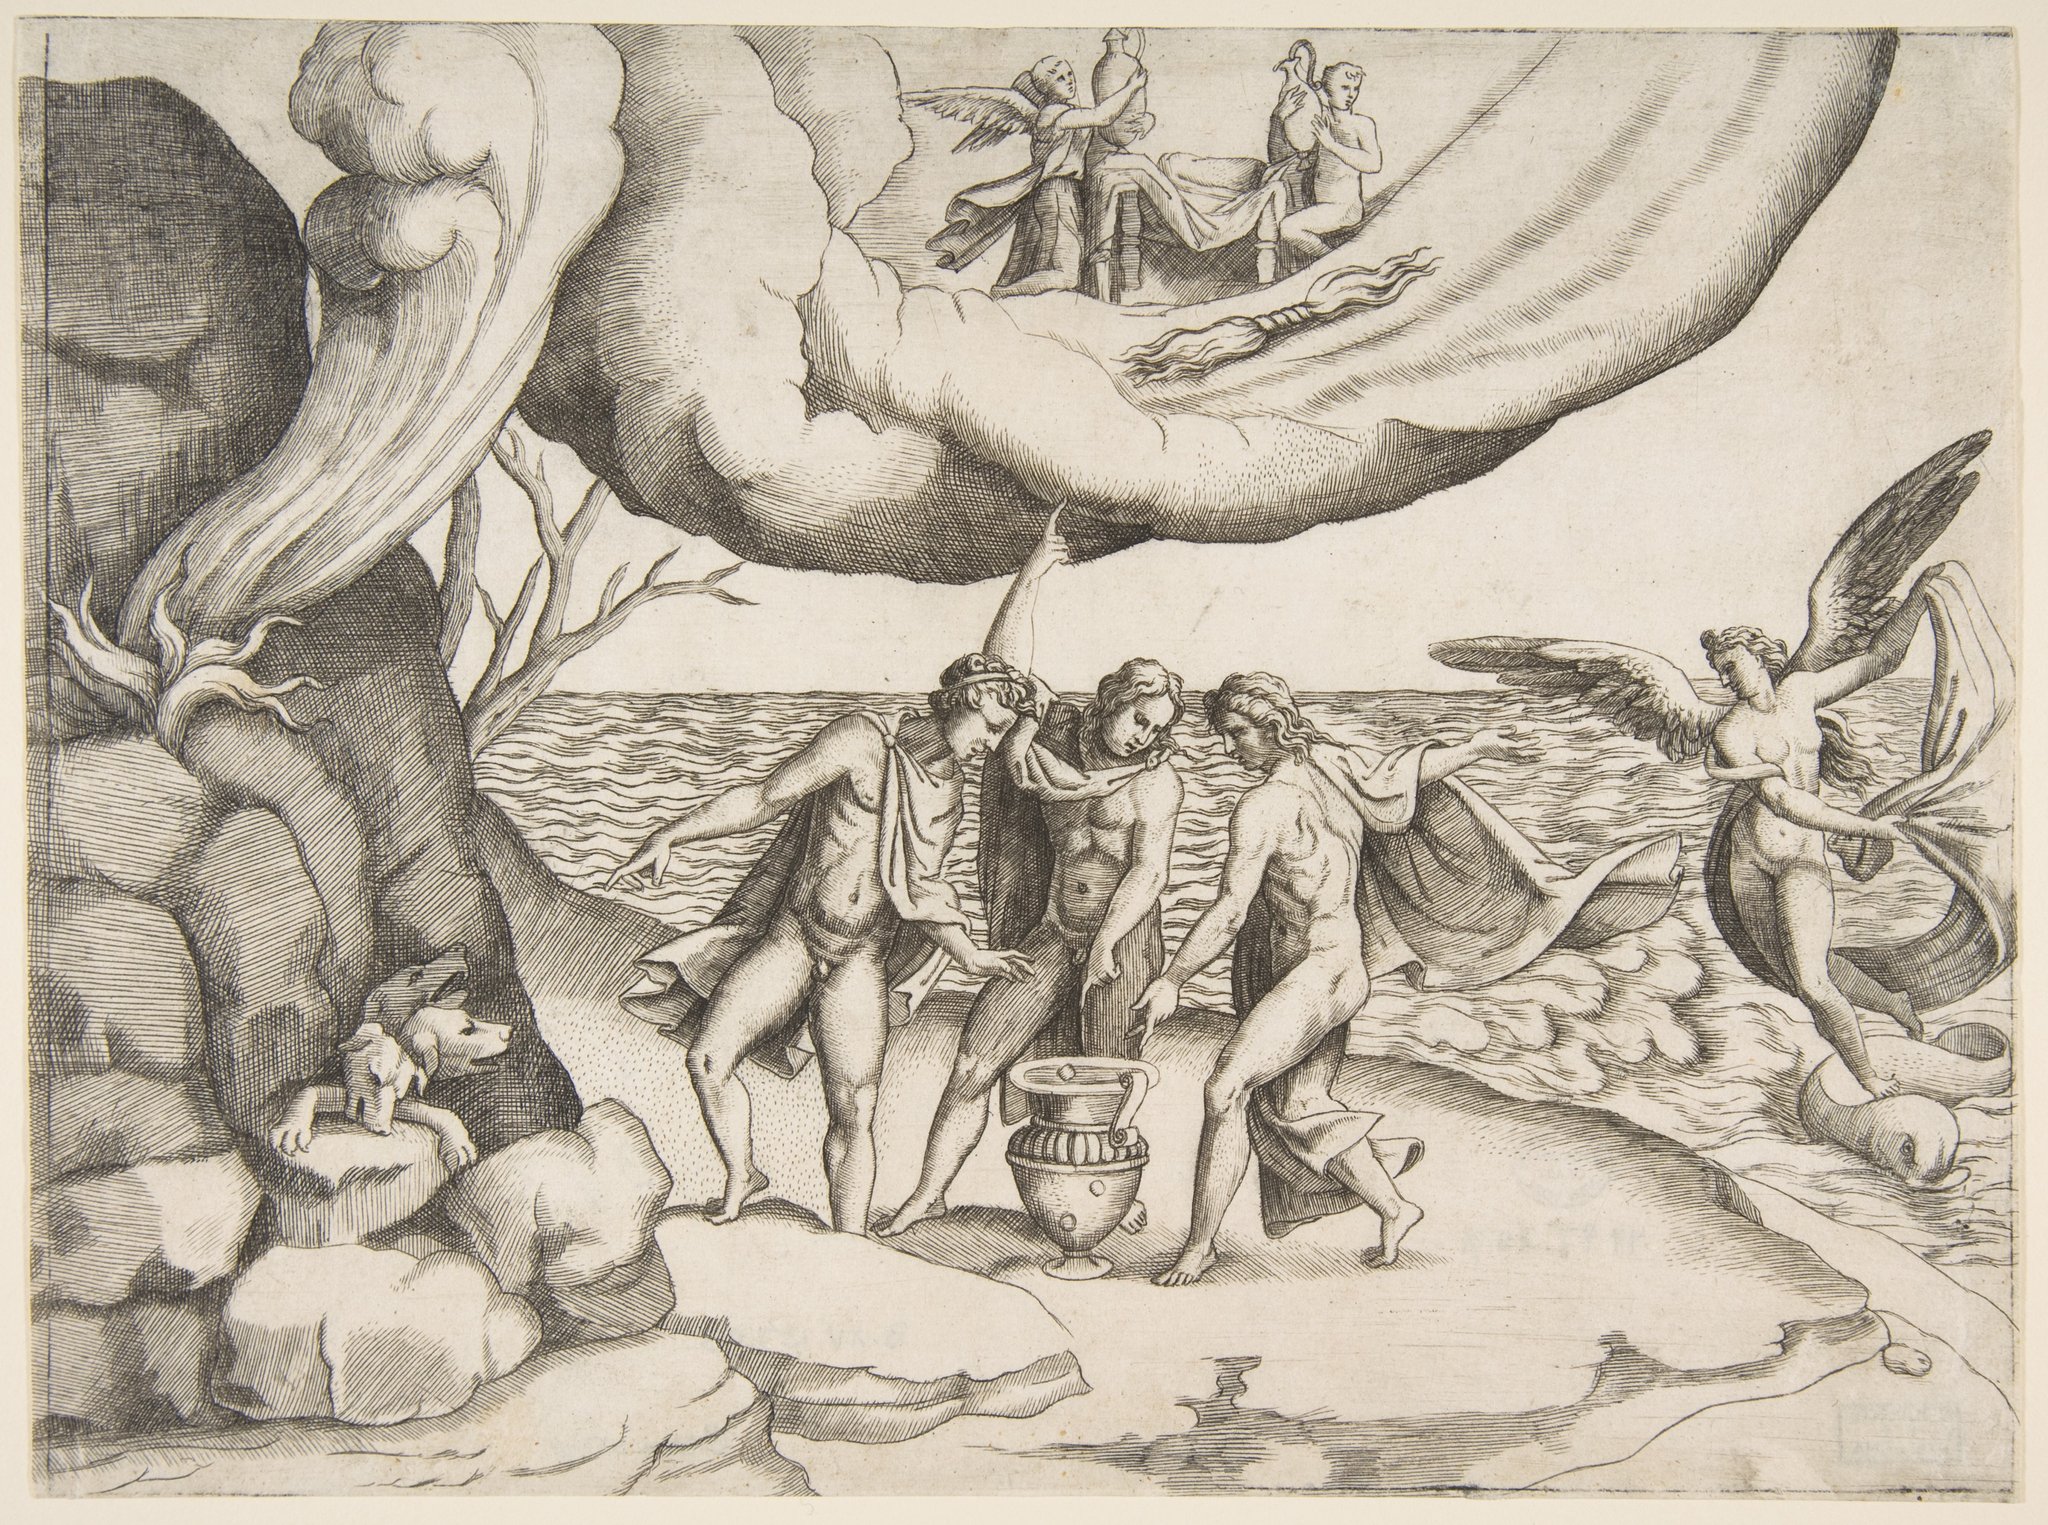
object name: print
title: Jupiter, Neptune and Pluto dividing the universe, from "Division of the Universe"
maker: giulio bonasone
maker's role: artist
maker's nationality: italian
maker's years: 1510-1576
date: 1531-1576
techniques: engraving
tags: jupiter,neptune,dogs,pluto